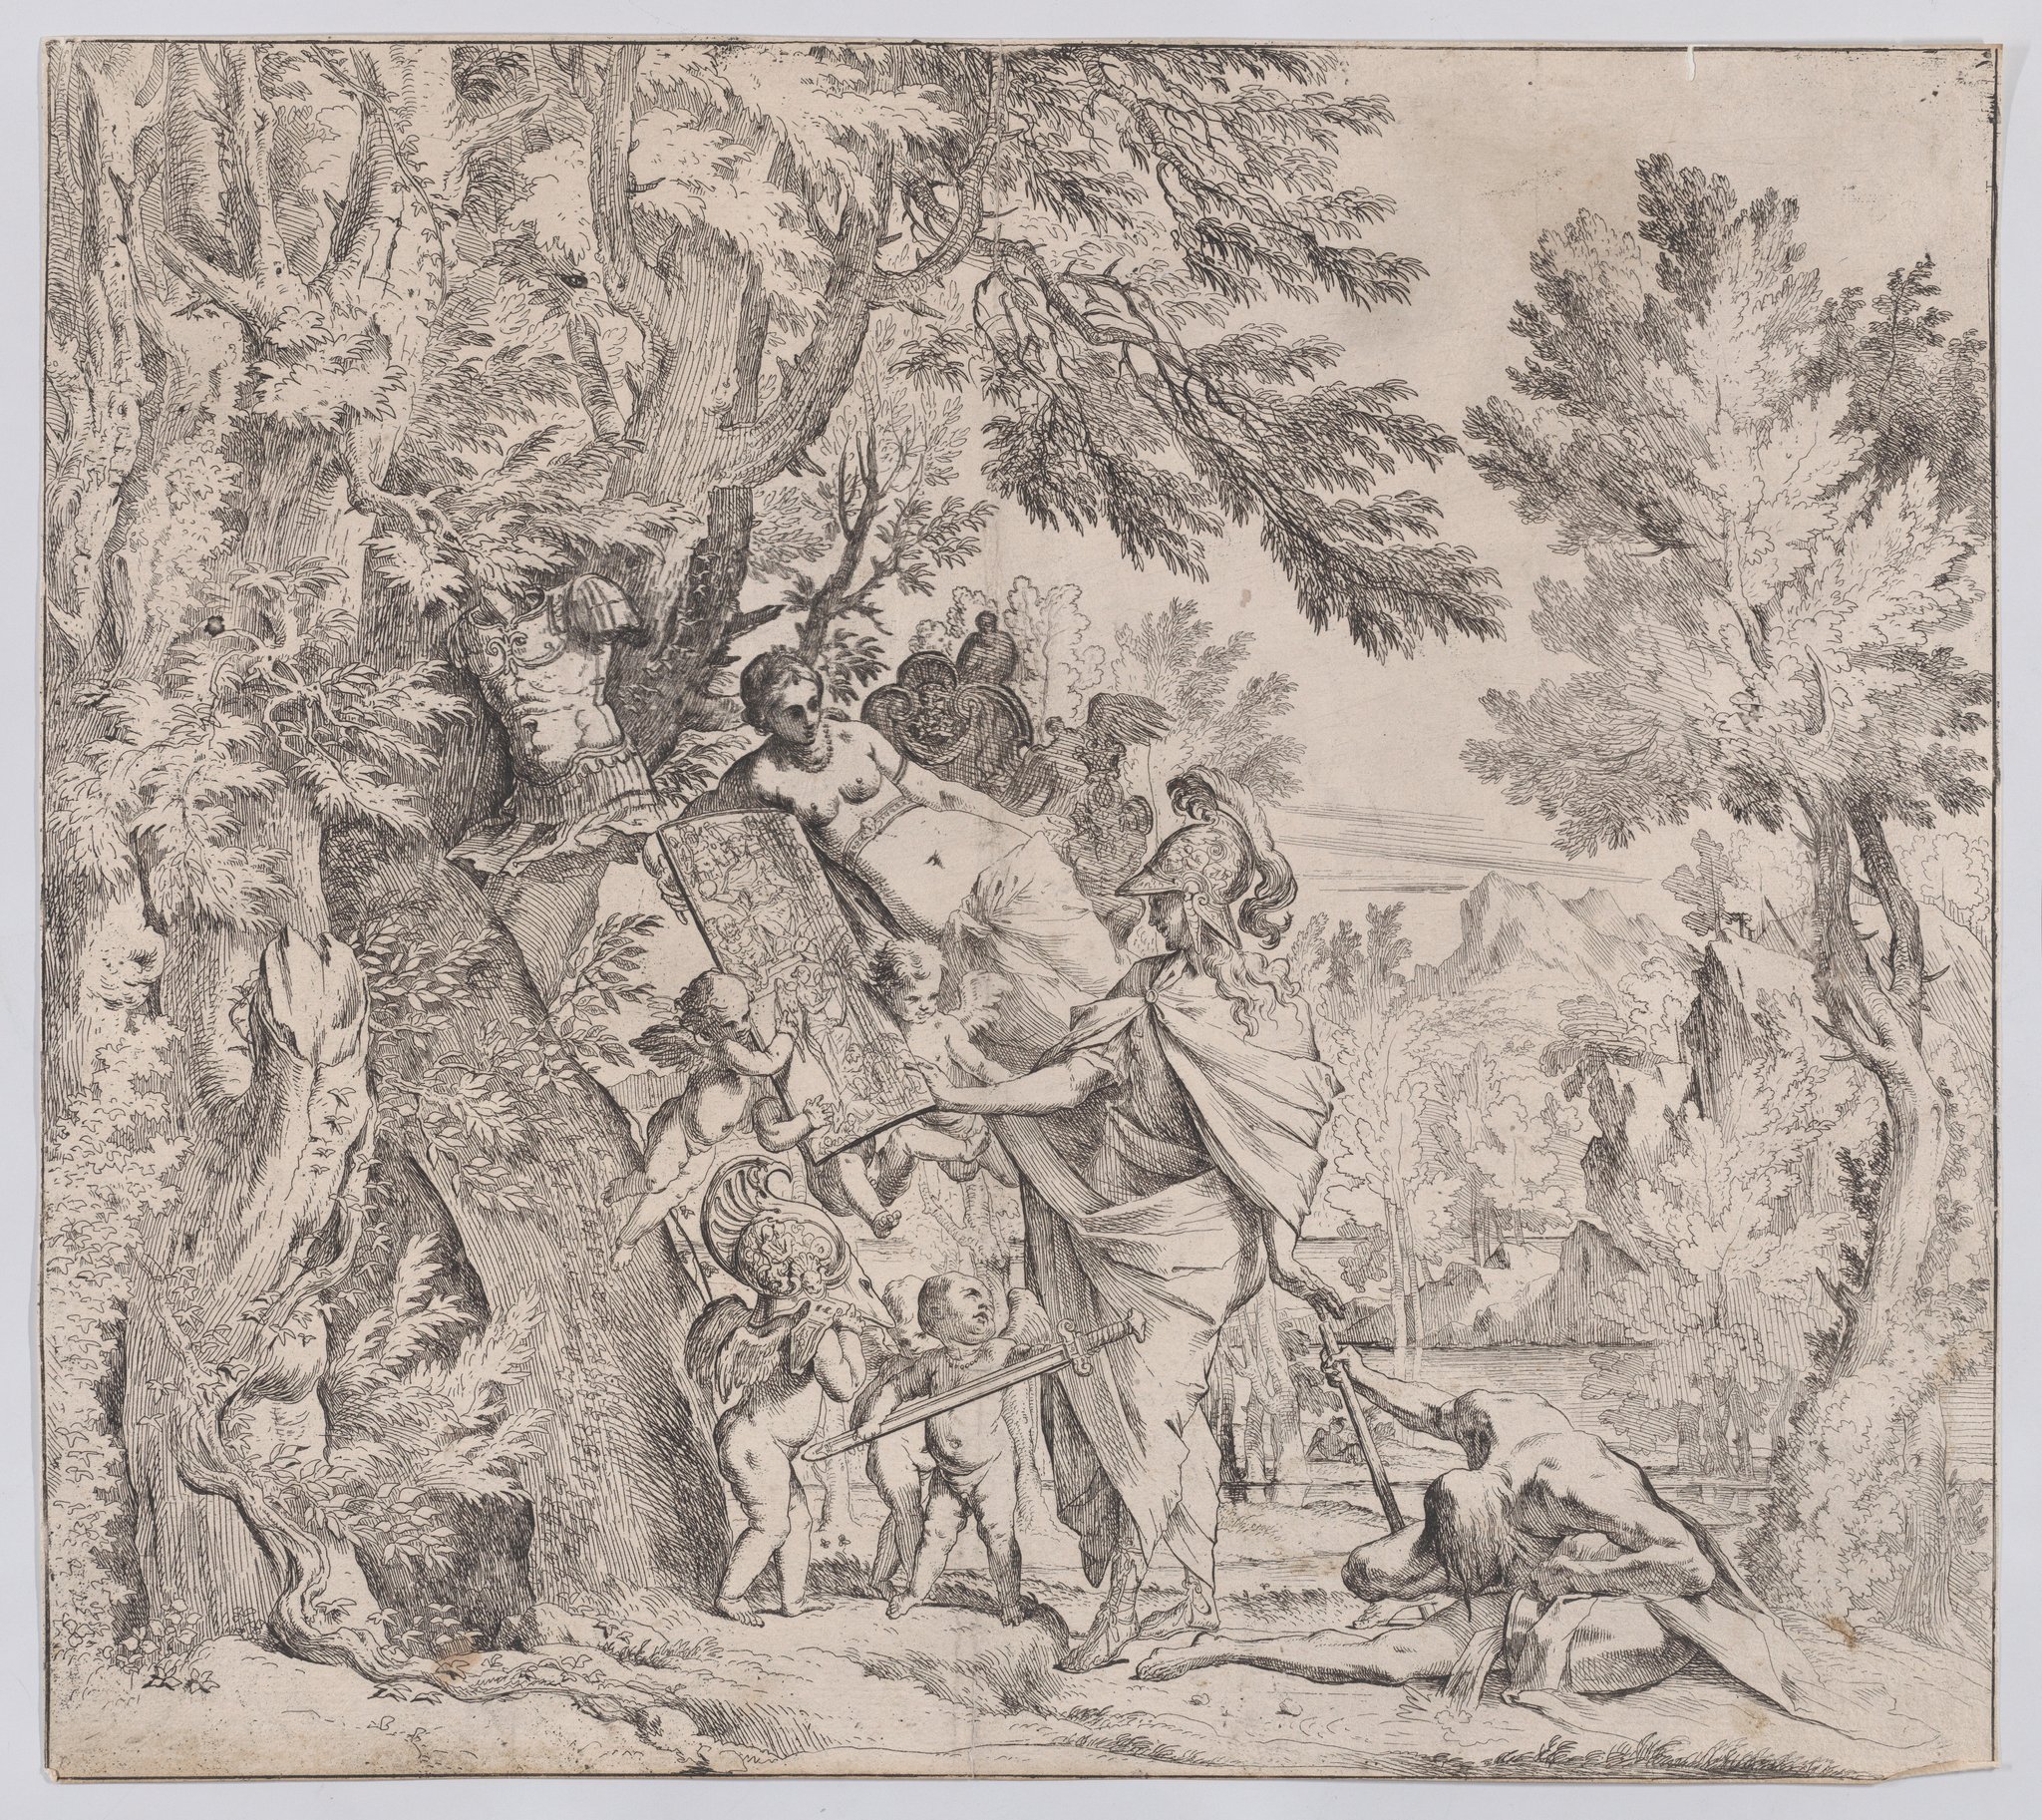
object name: print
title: Venus Giving Arms to Aeneas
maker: pietro testa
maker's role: artist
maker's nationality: italian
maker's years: 1612-1650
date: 1638-1640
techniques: etching